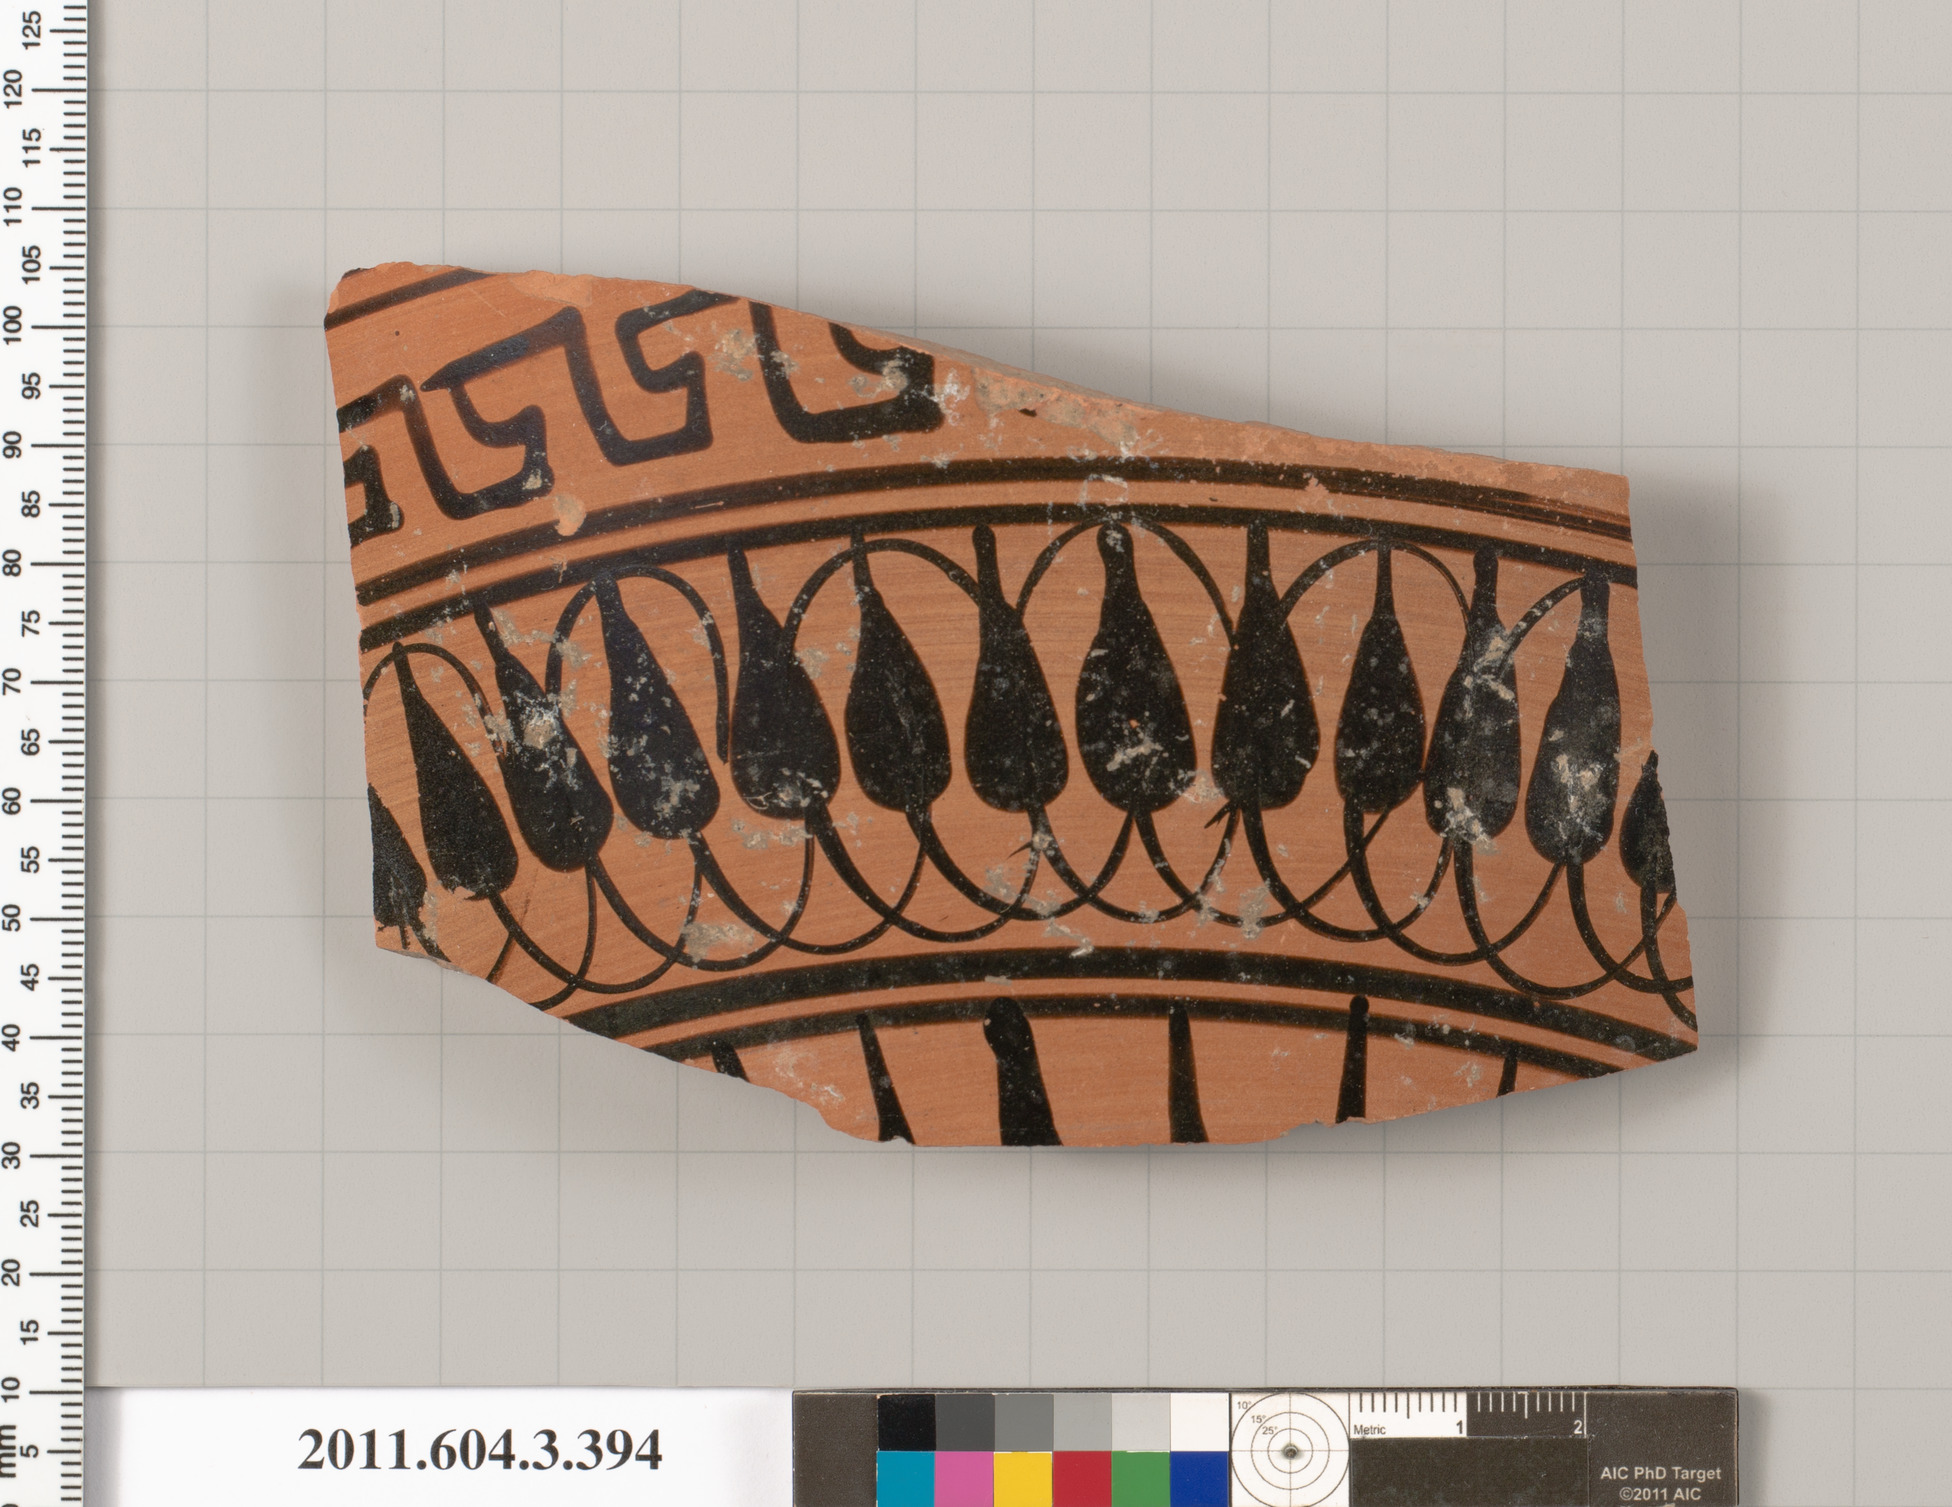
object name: neck amphora fragment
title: Terracotta fragment of a neck-amphora (jar)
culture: greek, attic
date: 520 BCE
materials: terracotta